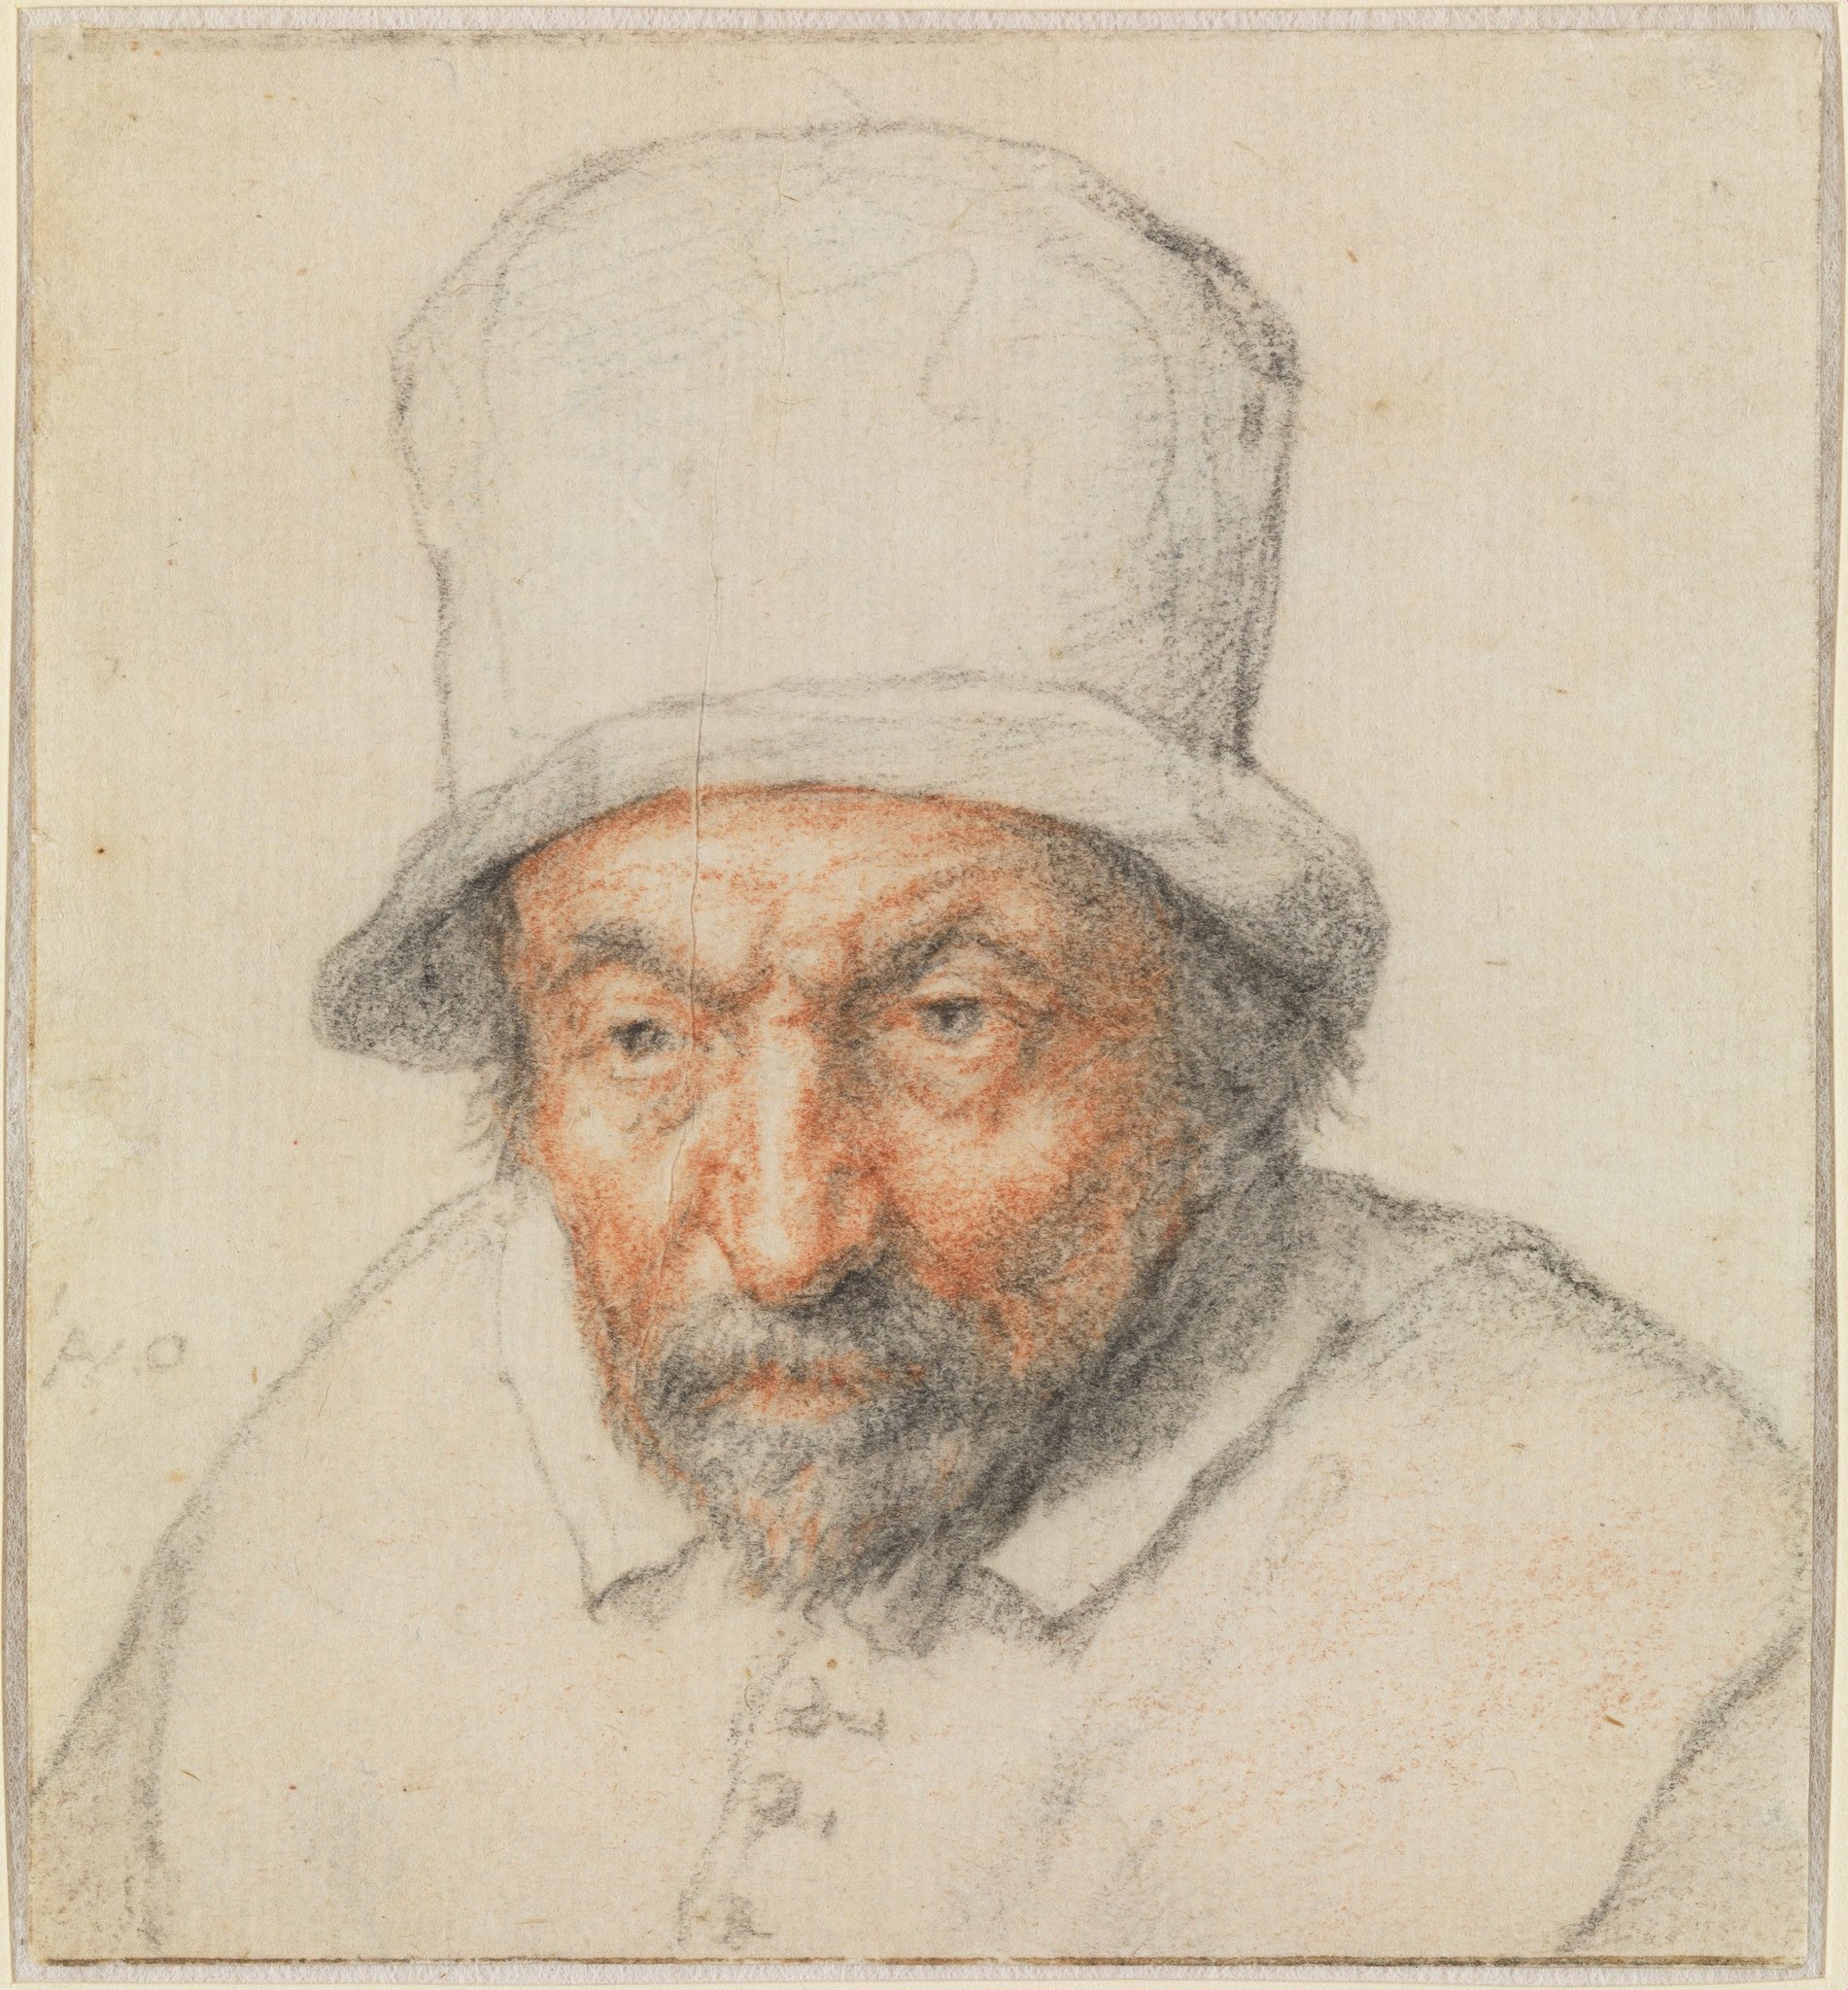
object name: drawing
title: Head of a Bearded Man in a Hat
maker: adriaen van ostade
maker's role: artist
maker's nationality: dutch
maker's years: 1610-1685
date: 1650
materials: chalk, pastel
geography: netherlands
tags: men,portraits